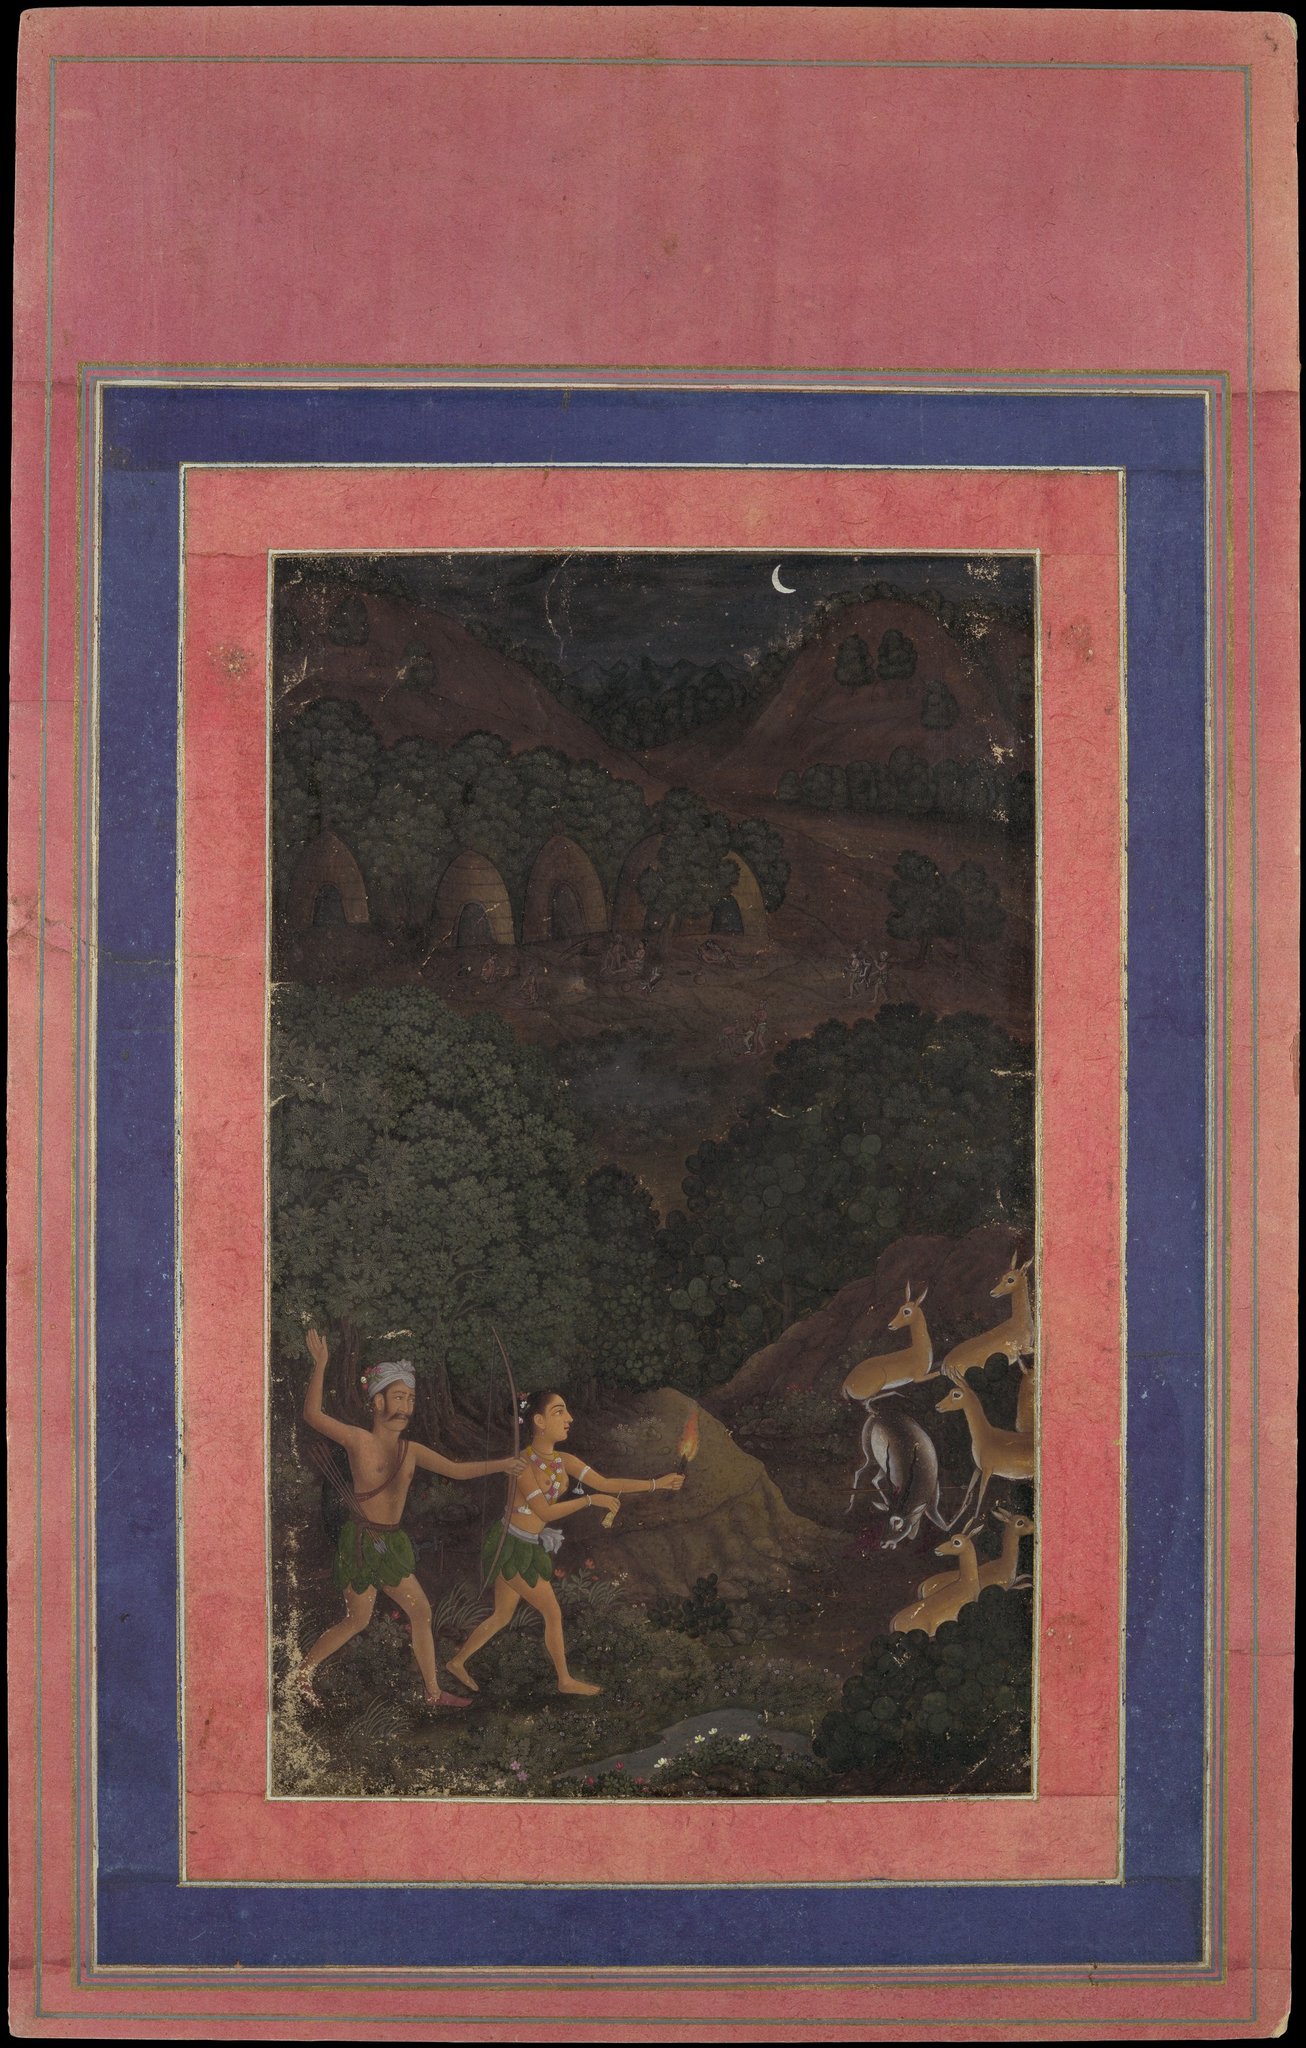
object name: illustrated album leaf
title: "Bhil Couple Hunting Deer at Night", Folio from the Davis Album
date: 1734-1766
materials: gold, ink, paper, watercolor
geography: india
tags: couples,men,women,hunting,deer